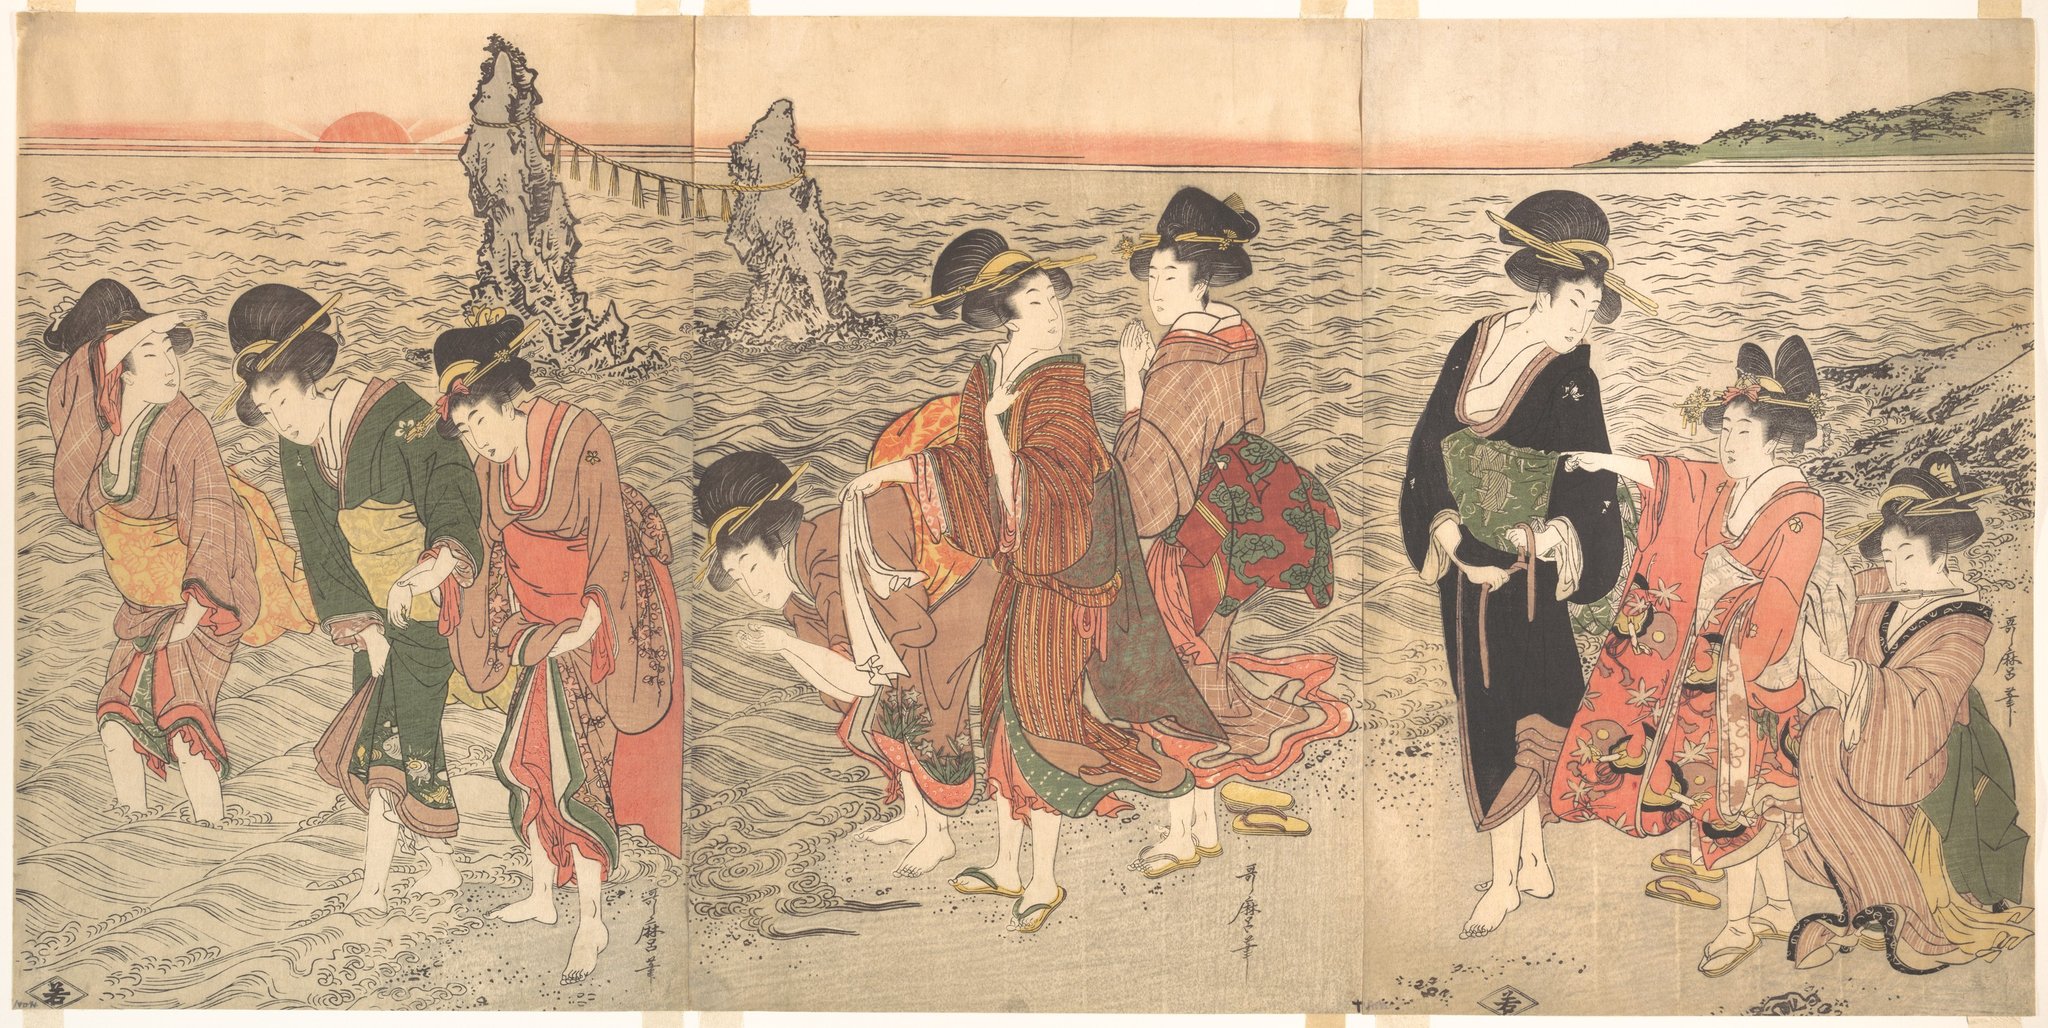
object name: print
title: Women Worshipping the Rising Sun between the Twin Rocks at Ise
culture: japanese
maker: kitagawa utamaro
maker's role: artist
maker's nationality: japanese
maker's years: 1754-1806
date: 1754-1806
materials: ink, paper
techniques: woodblock print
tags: women,rivers,sun,praying